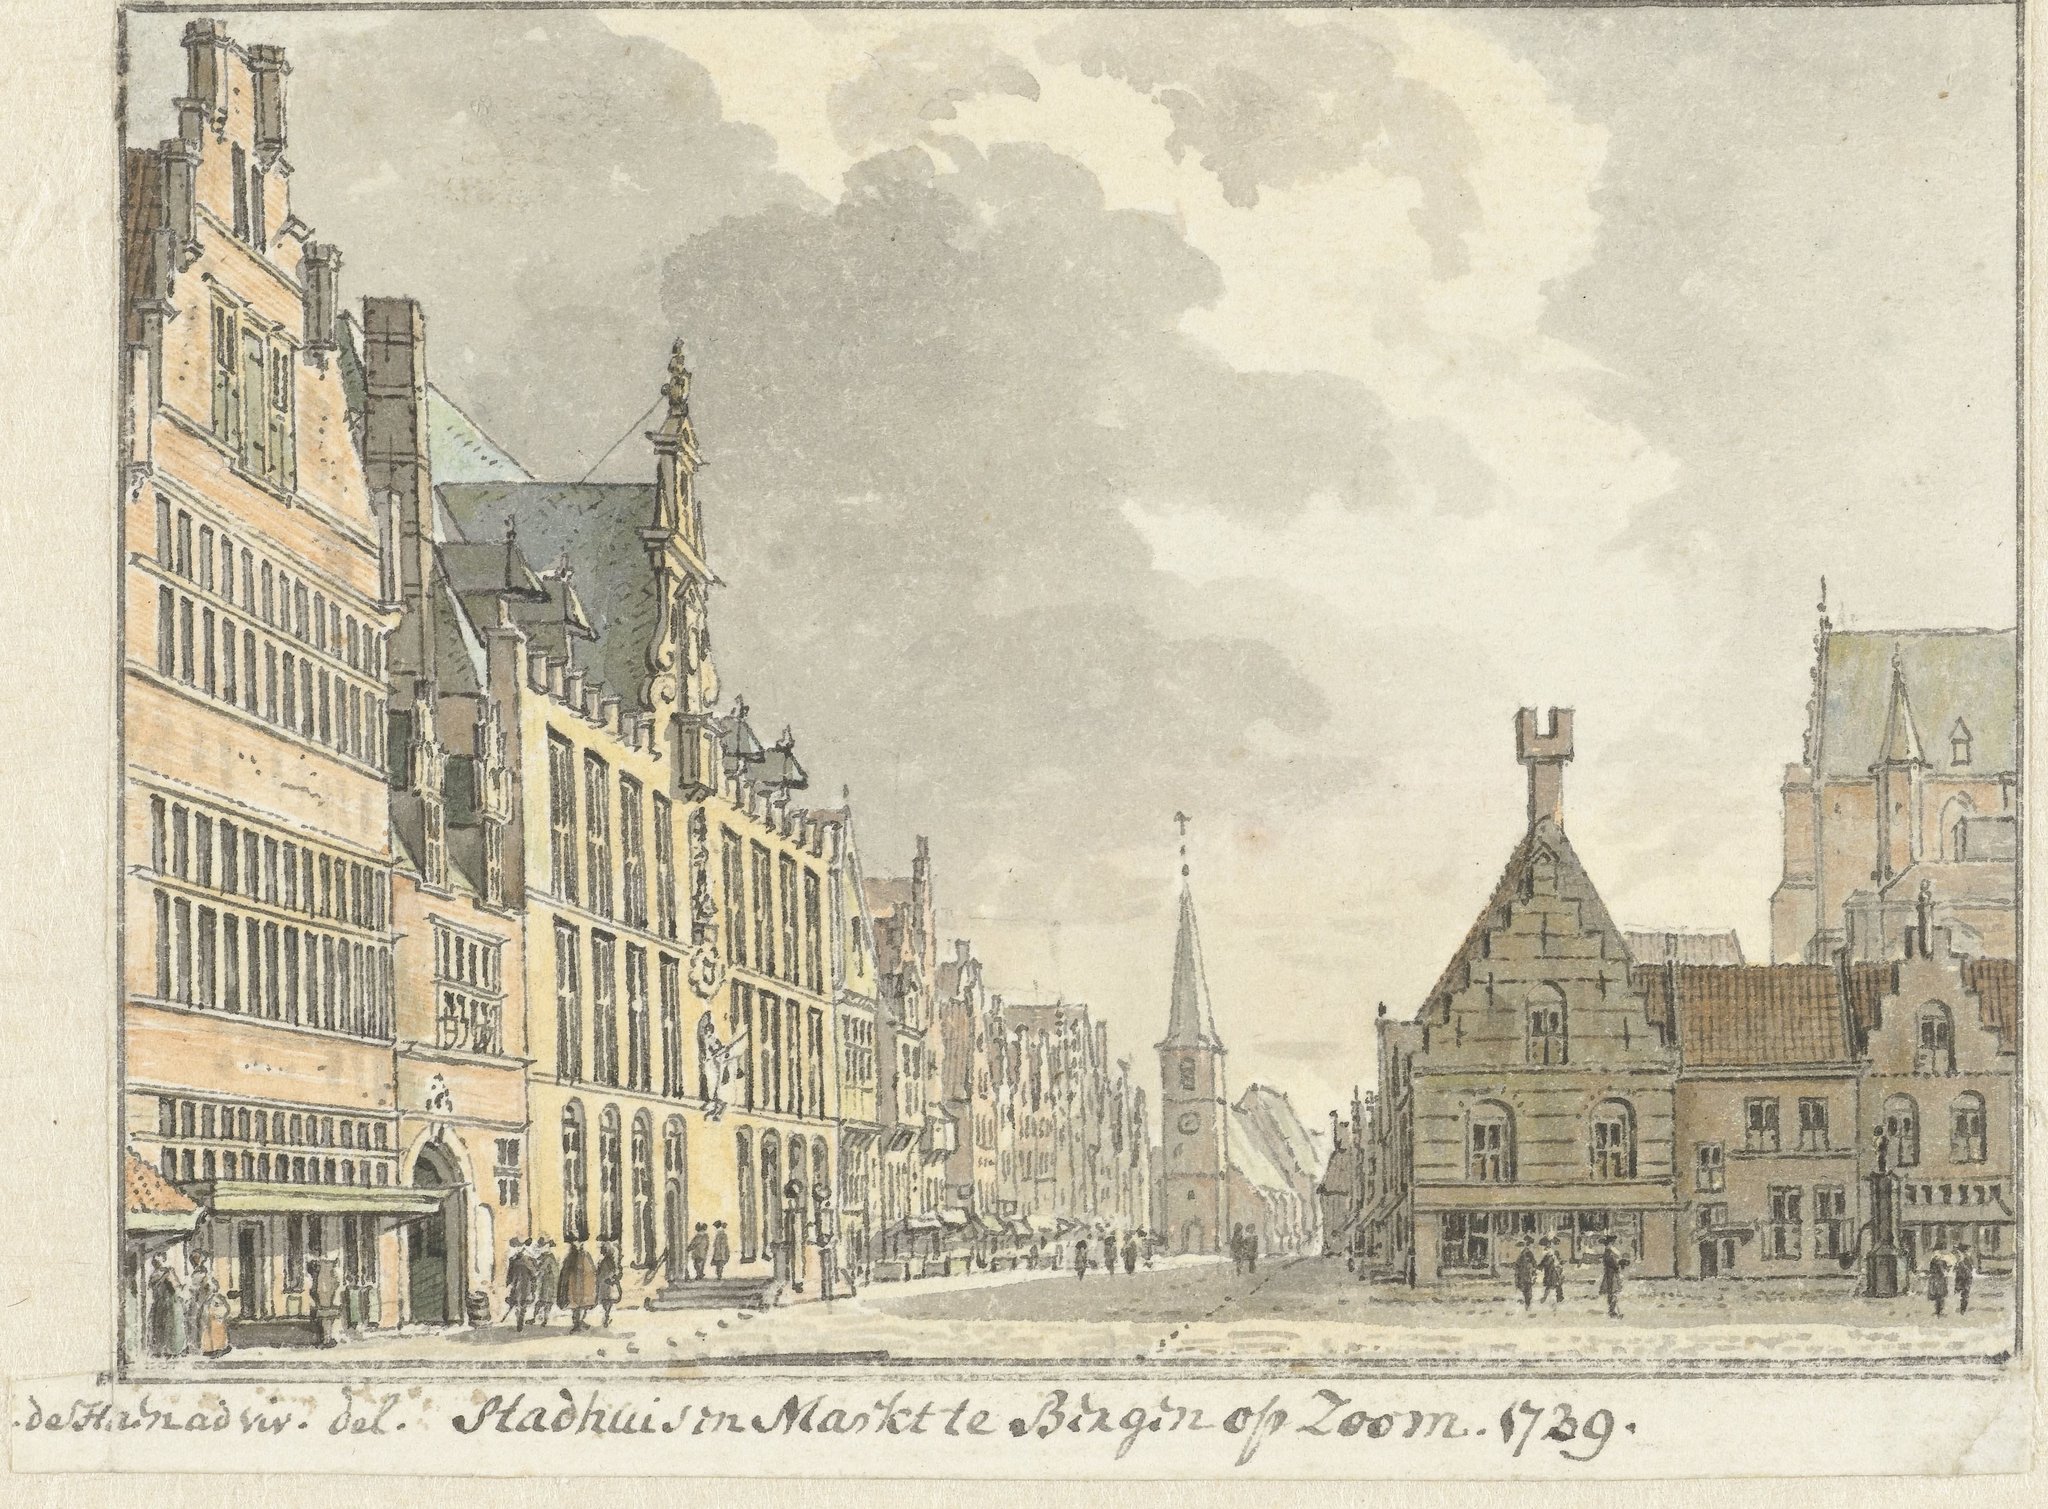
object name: drawing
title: Stadhuis en Markt te Bergen op Zoom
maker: abraham de haen (ii)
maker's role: draughtsman, print maker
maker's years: 1707-1748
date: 1739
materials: ink, paper, pencil, watercolor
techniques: brush, pen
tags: townhall, public road